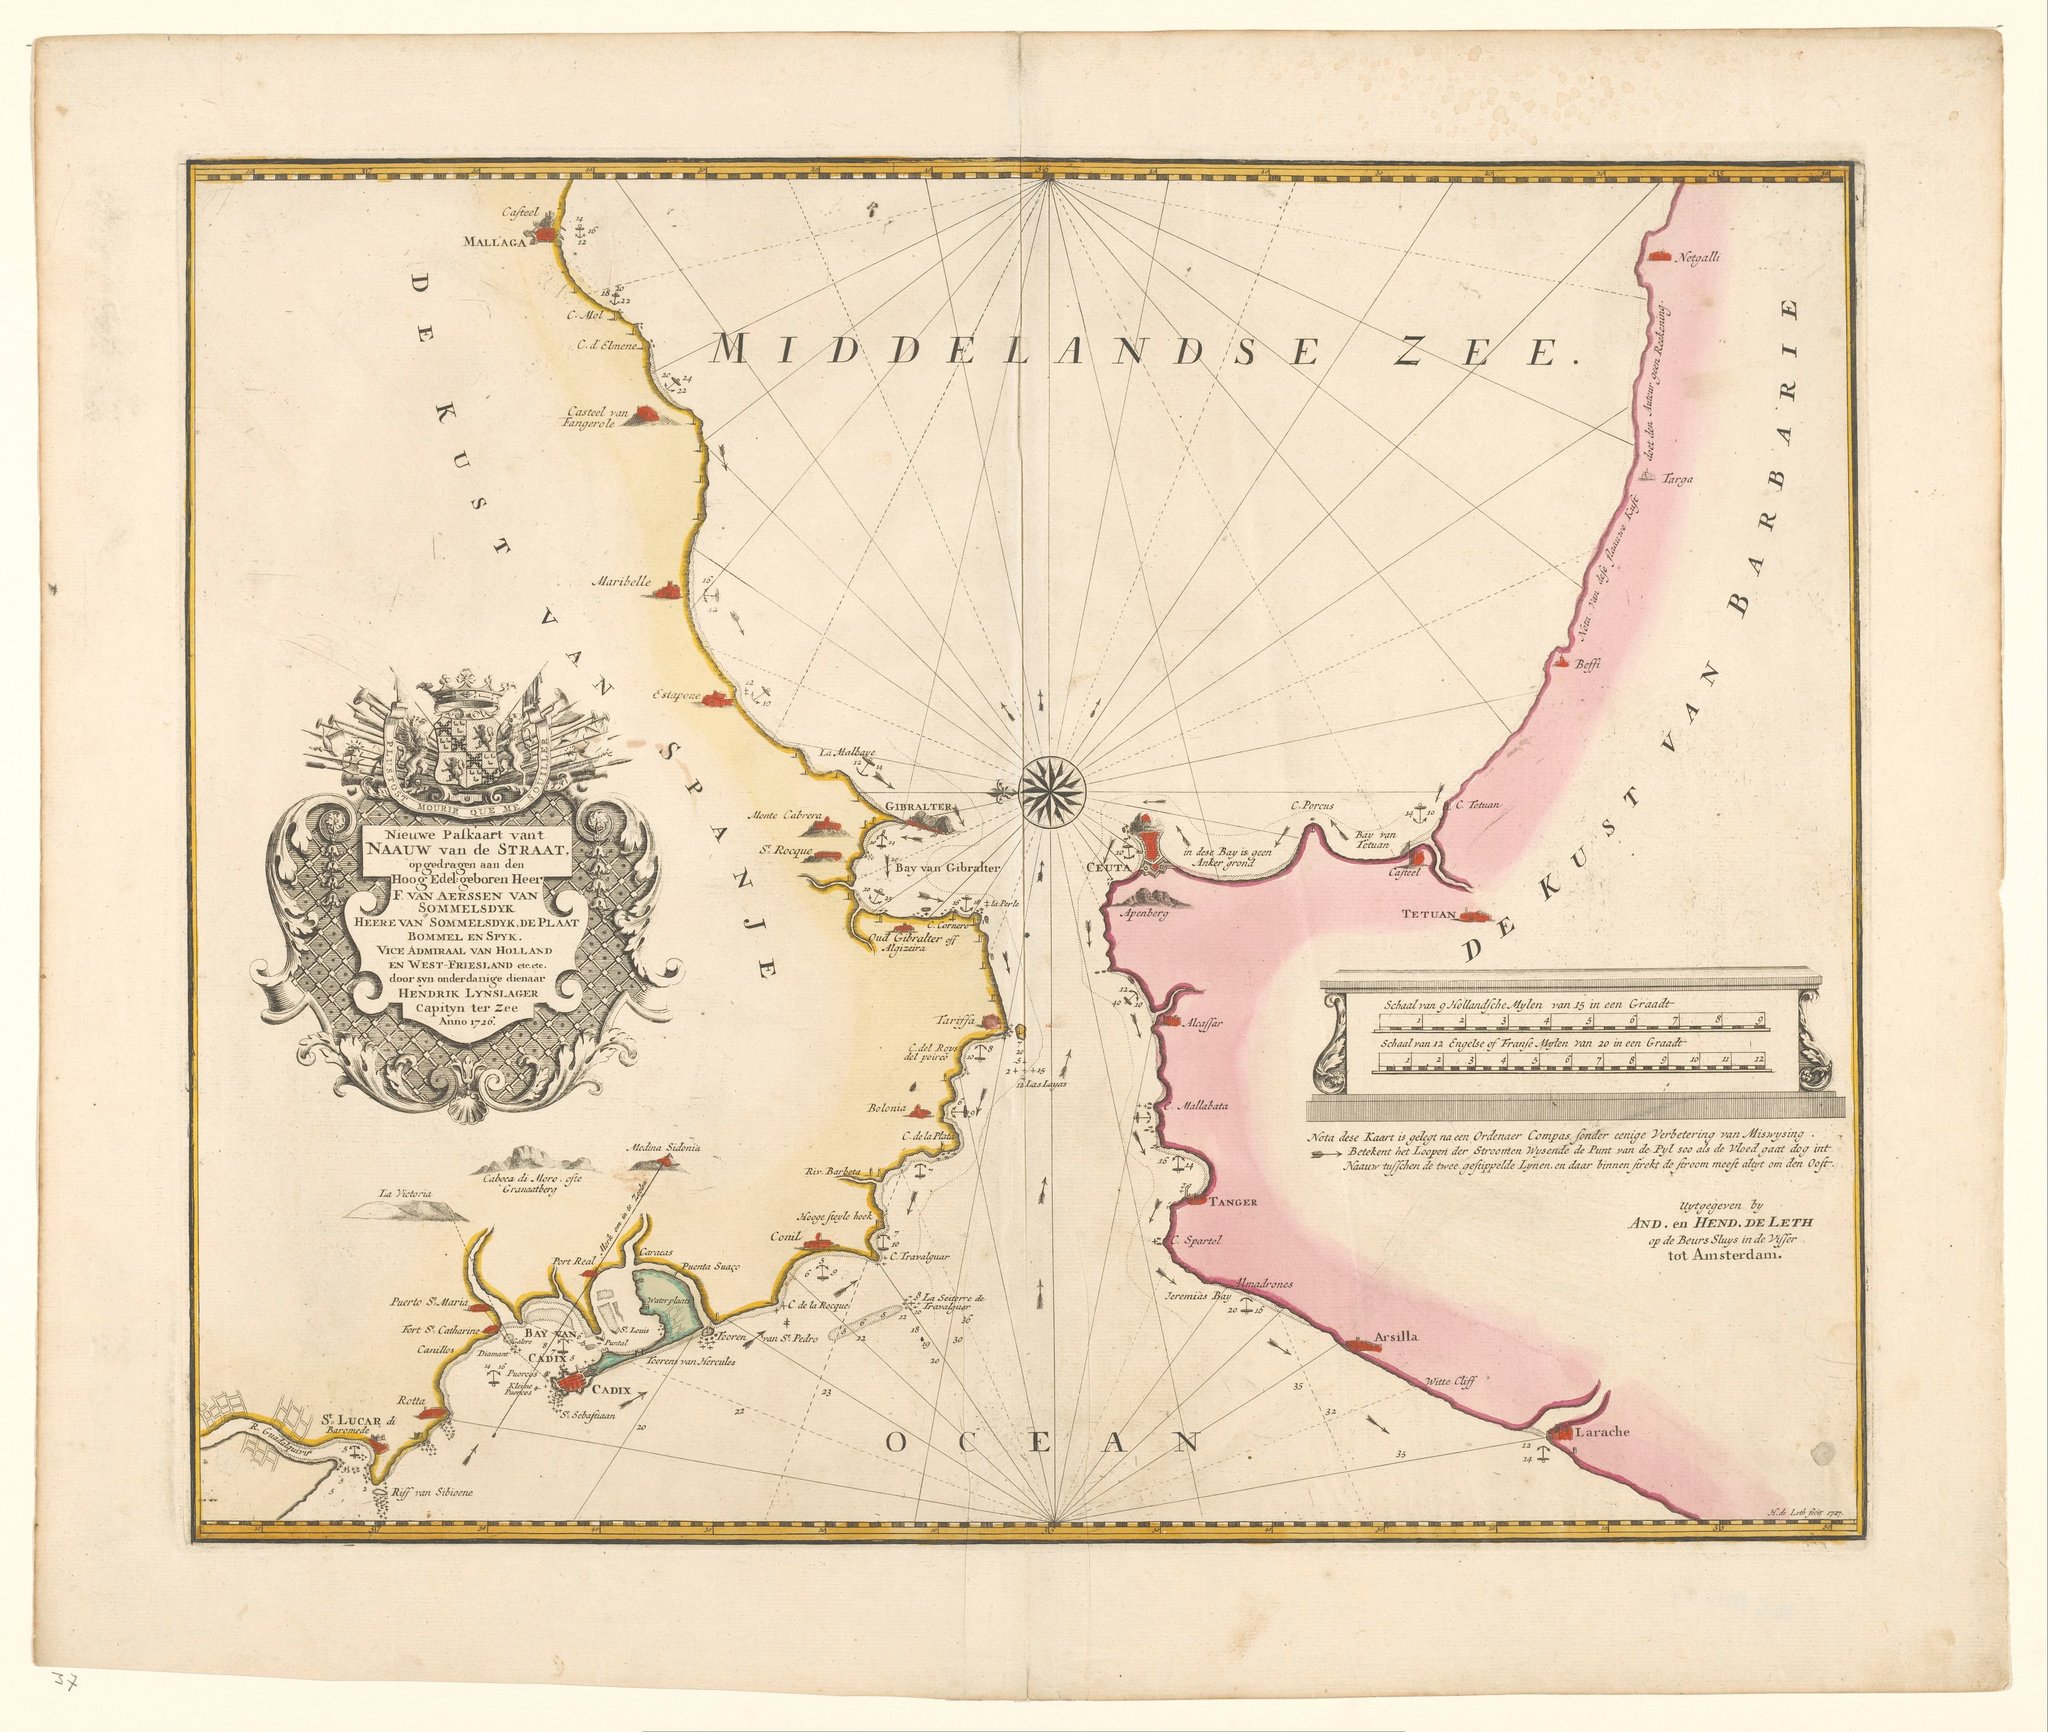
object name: map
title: Nieuwe Paskaart vant Naauw van de Straat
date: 1726-1727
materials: paper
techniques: engraving, hand coloring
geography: amsterdam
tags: paris, françois van aerssen, marine charts, spain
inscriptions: date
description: Zeekaart van de Straat van Gibraltar met de kusten van Spanje en de kust van het huidige Marokko, hier aangeduid als 'Barbarie'. In de Middellandse Zee een kompasroos, het noorden ligt links. Links een cartouche met titel en de opdracht aan F. van Aerssen van Sommelsdyk, vice-admiraal van Holland en West-Friesland. De cartouche met gekroond wapenschild. Rechtsmidden twee schaalstokken met Hollandse en Engelse of Franse mijlen.